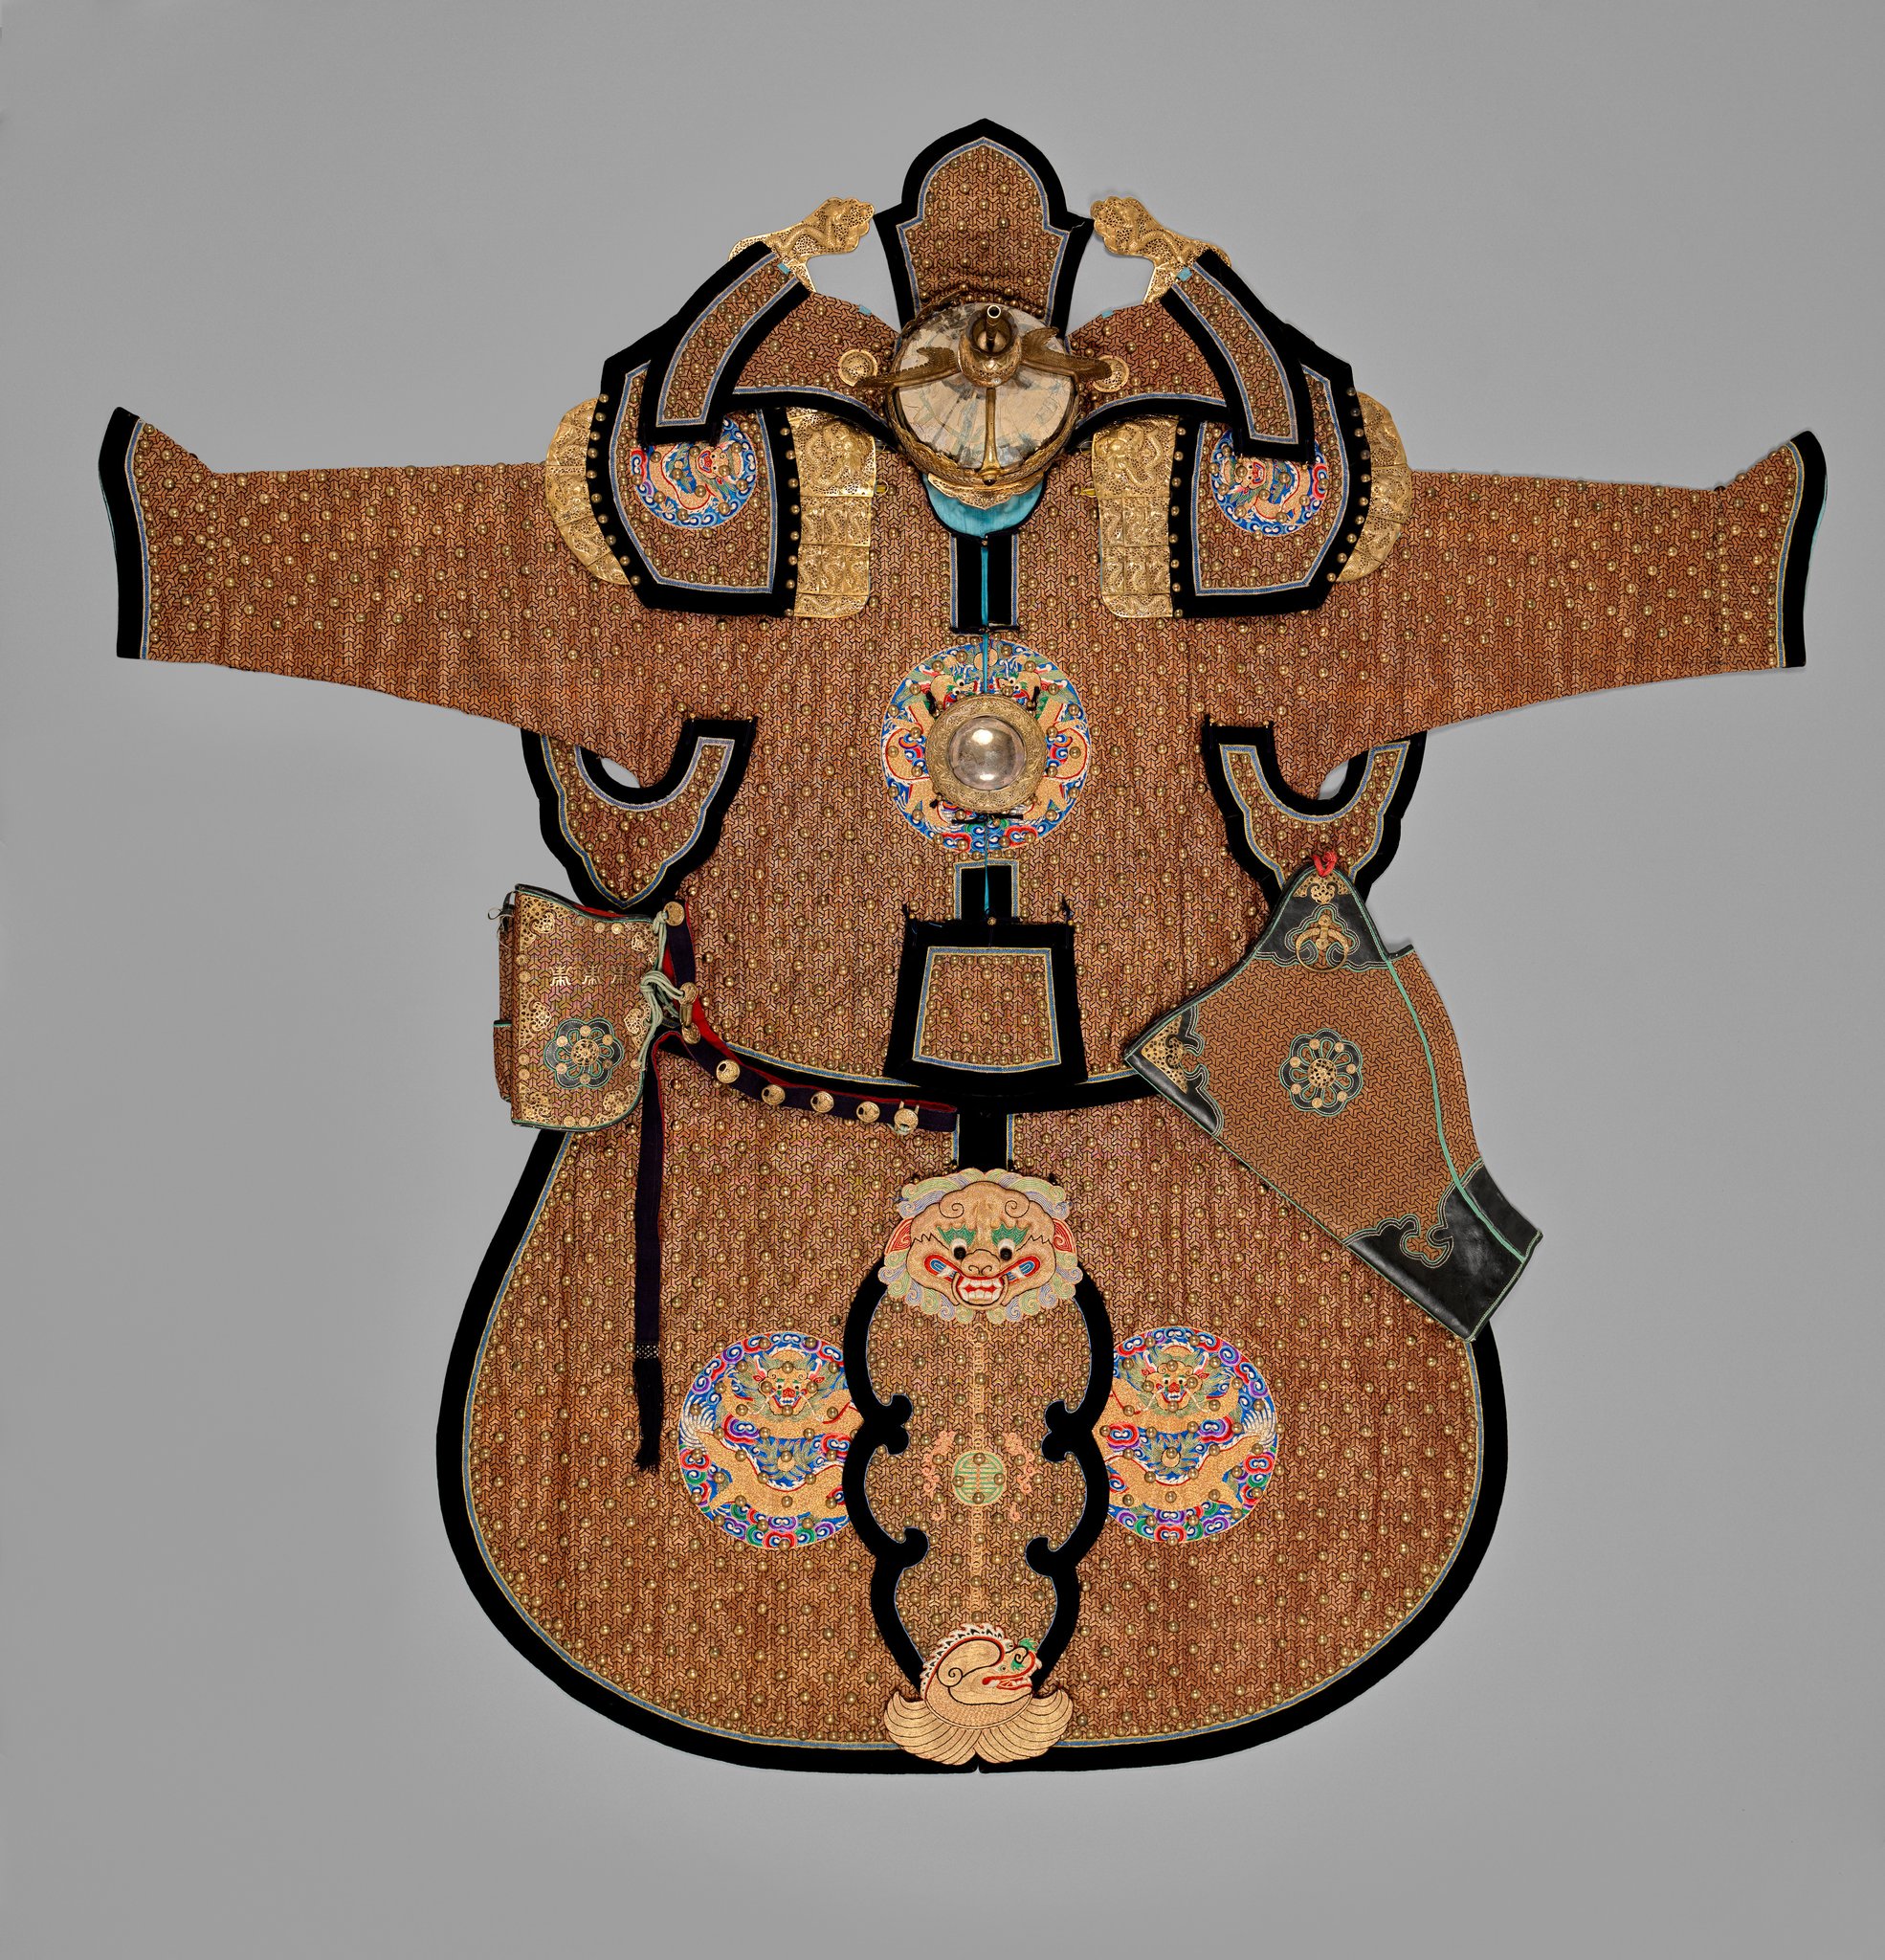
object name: armor with archery equipment and box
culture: chinese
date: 1875-1900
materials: copper alloy, gold, lacquer, leather, paper, pigment, silver, steel, textile, wood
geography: china